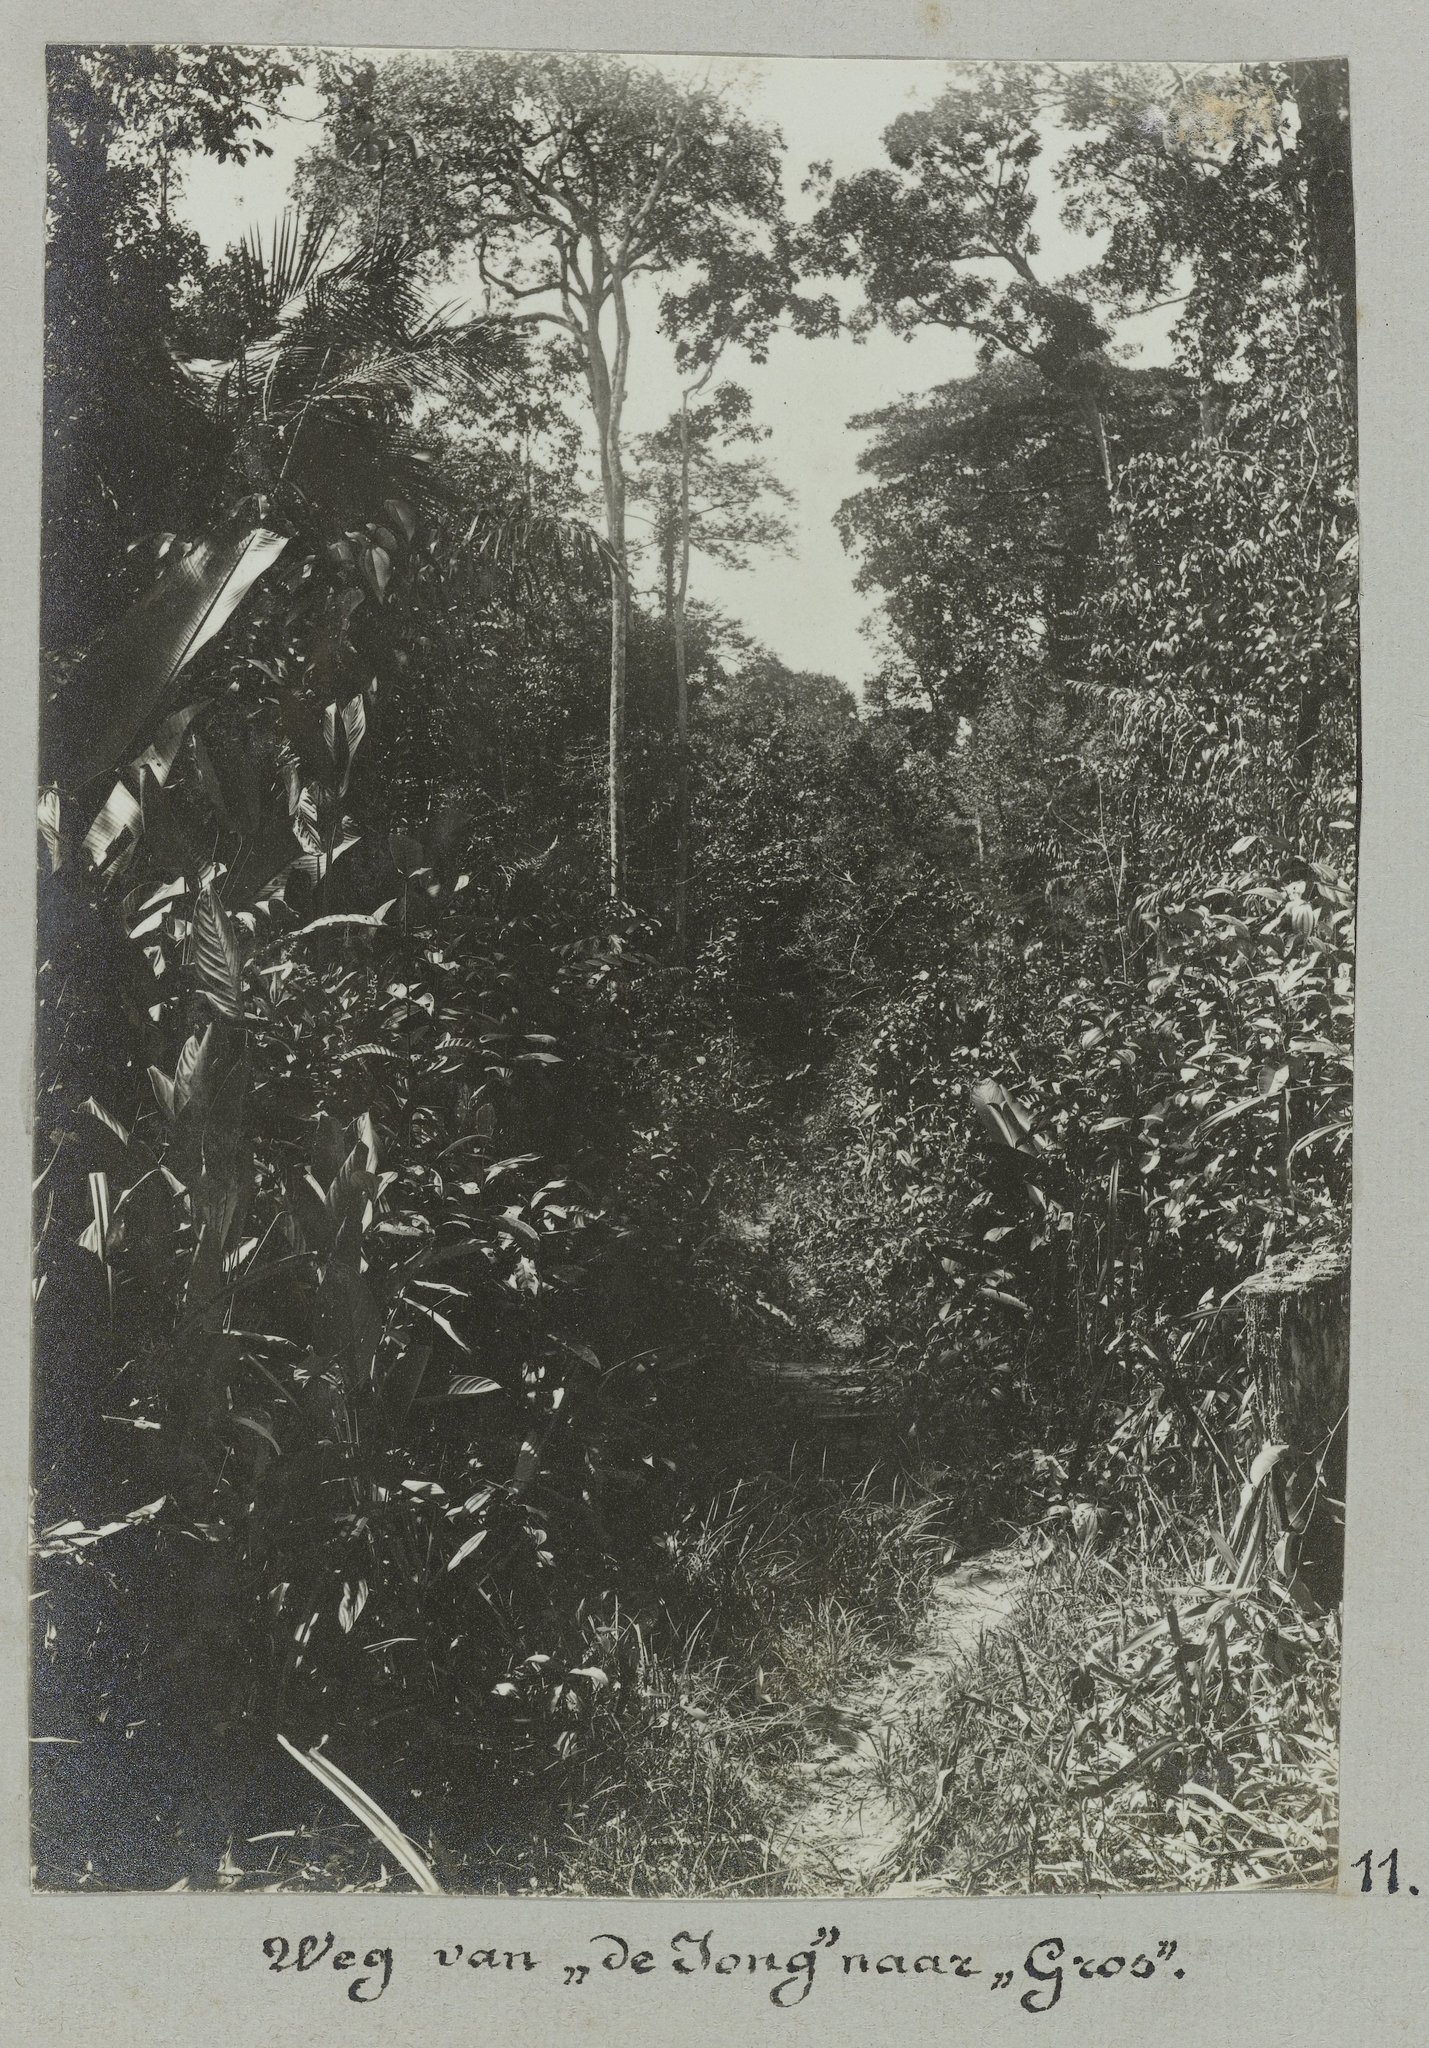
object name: photograph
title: Weg van "de Jong" naar "Gros"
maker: hendrik doijer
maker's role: engineer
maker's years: 1863-1925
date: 1903-1910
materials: photographic support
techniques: gelatin silver print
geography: suriname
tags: suriname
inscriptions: inscription: ‘12. / Weg van "de Jong" naar "Gros".’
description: Weg tussen bomen; op basis van het onderschrift waarschijnlijk de weg van de placer van de gebroeders L. en F. de Jong naar de placer van Gros, in Oost-Suriname. Onderdeel van het fotoalbum Souvenir de Voyage (deel 1), over het leven van de familie Doijer in en rond de plantage Ma Retraite in Suriname in de jaren 1903-1910.